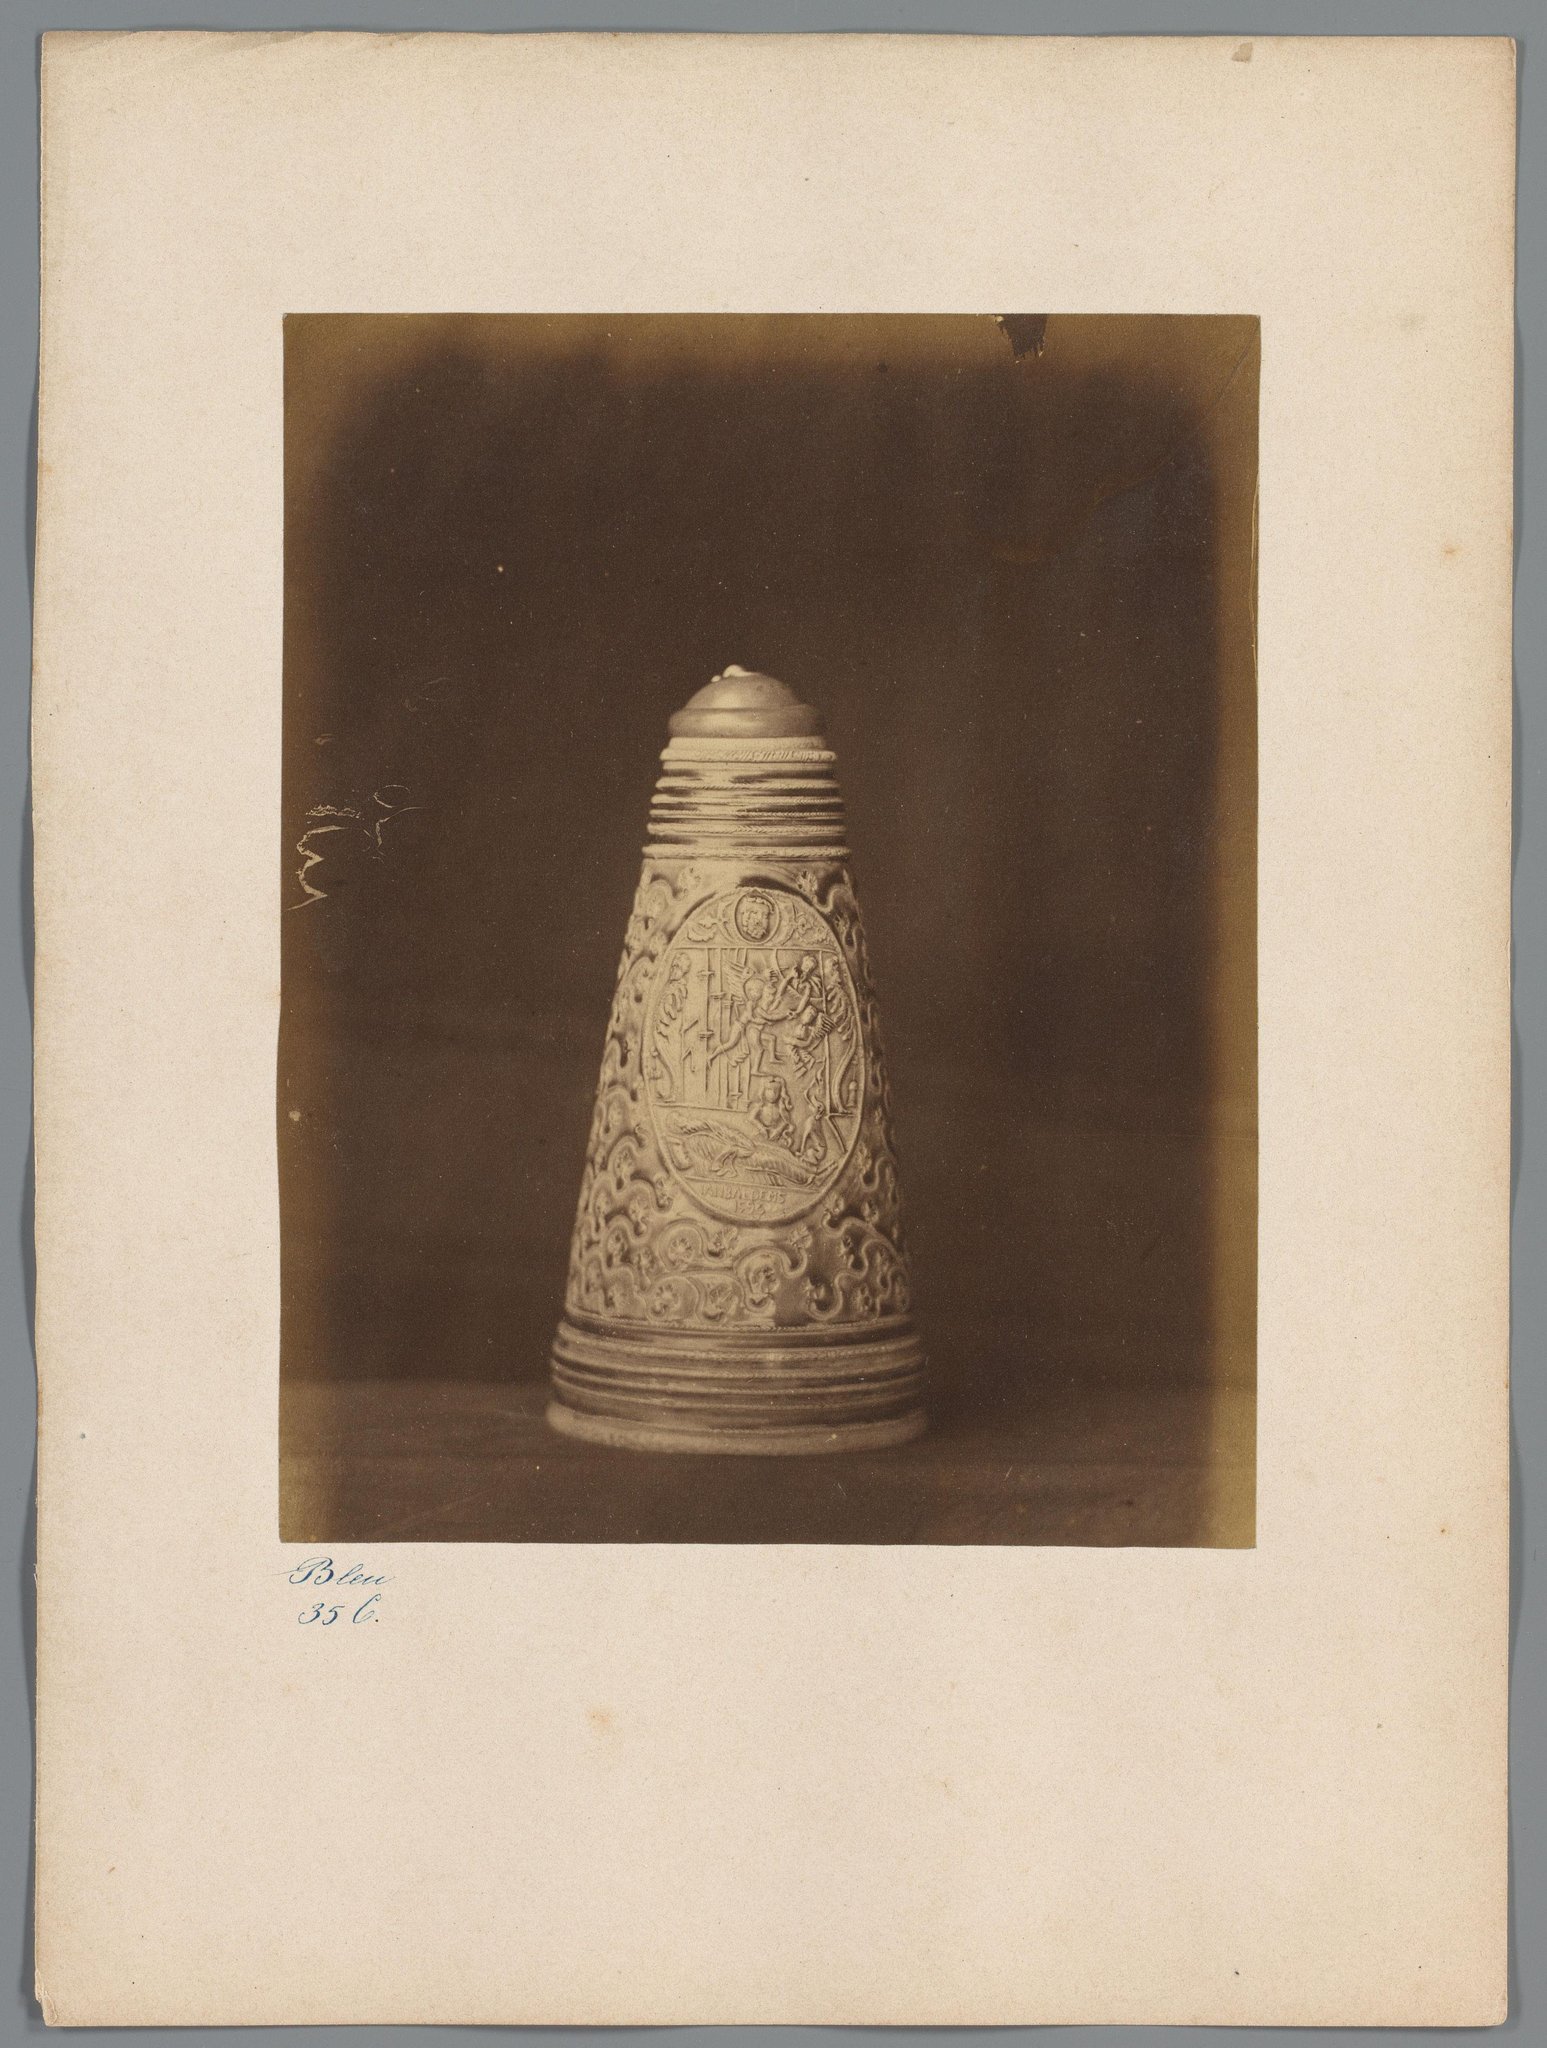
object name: photograph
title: Aardewerken vaas uit de collectie van W. de Weckherlin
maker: Anonymous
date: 1860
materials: paper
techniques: albumen print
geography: the hague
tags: container of ceramics: jar, jug, pot, vase, the hague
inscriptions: inscription: ‘Bleu./ 35G.’